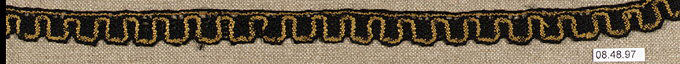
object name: edging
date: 1801-1900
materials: silk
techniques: lace